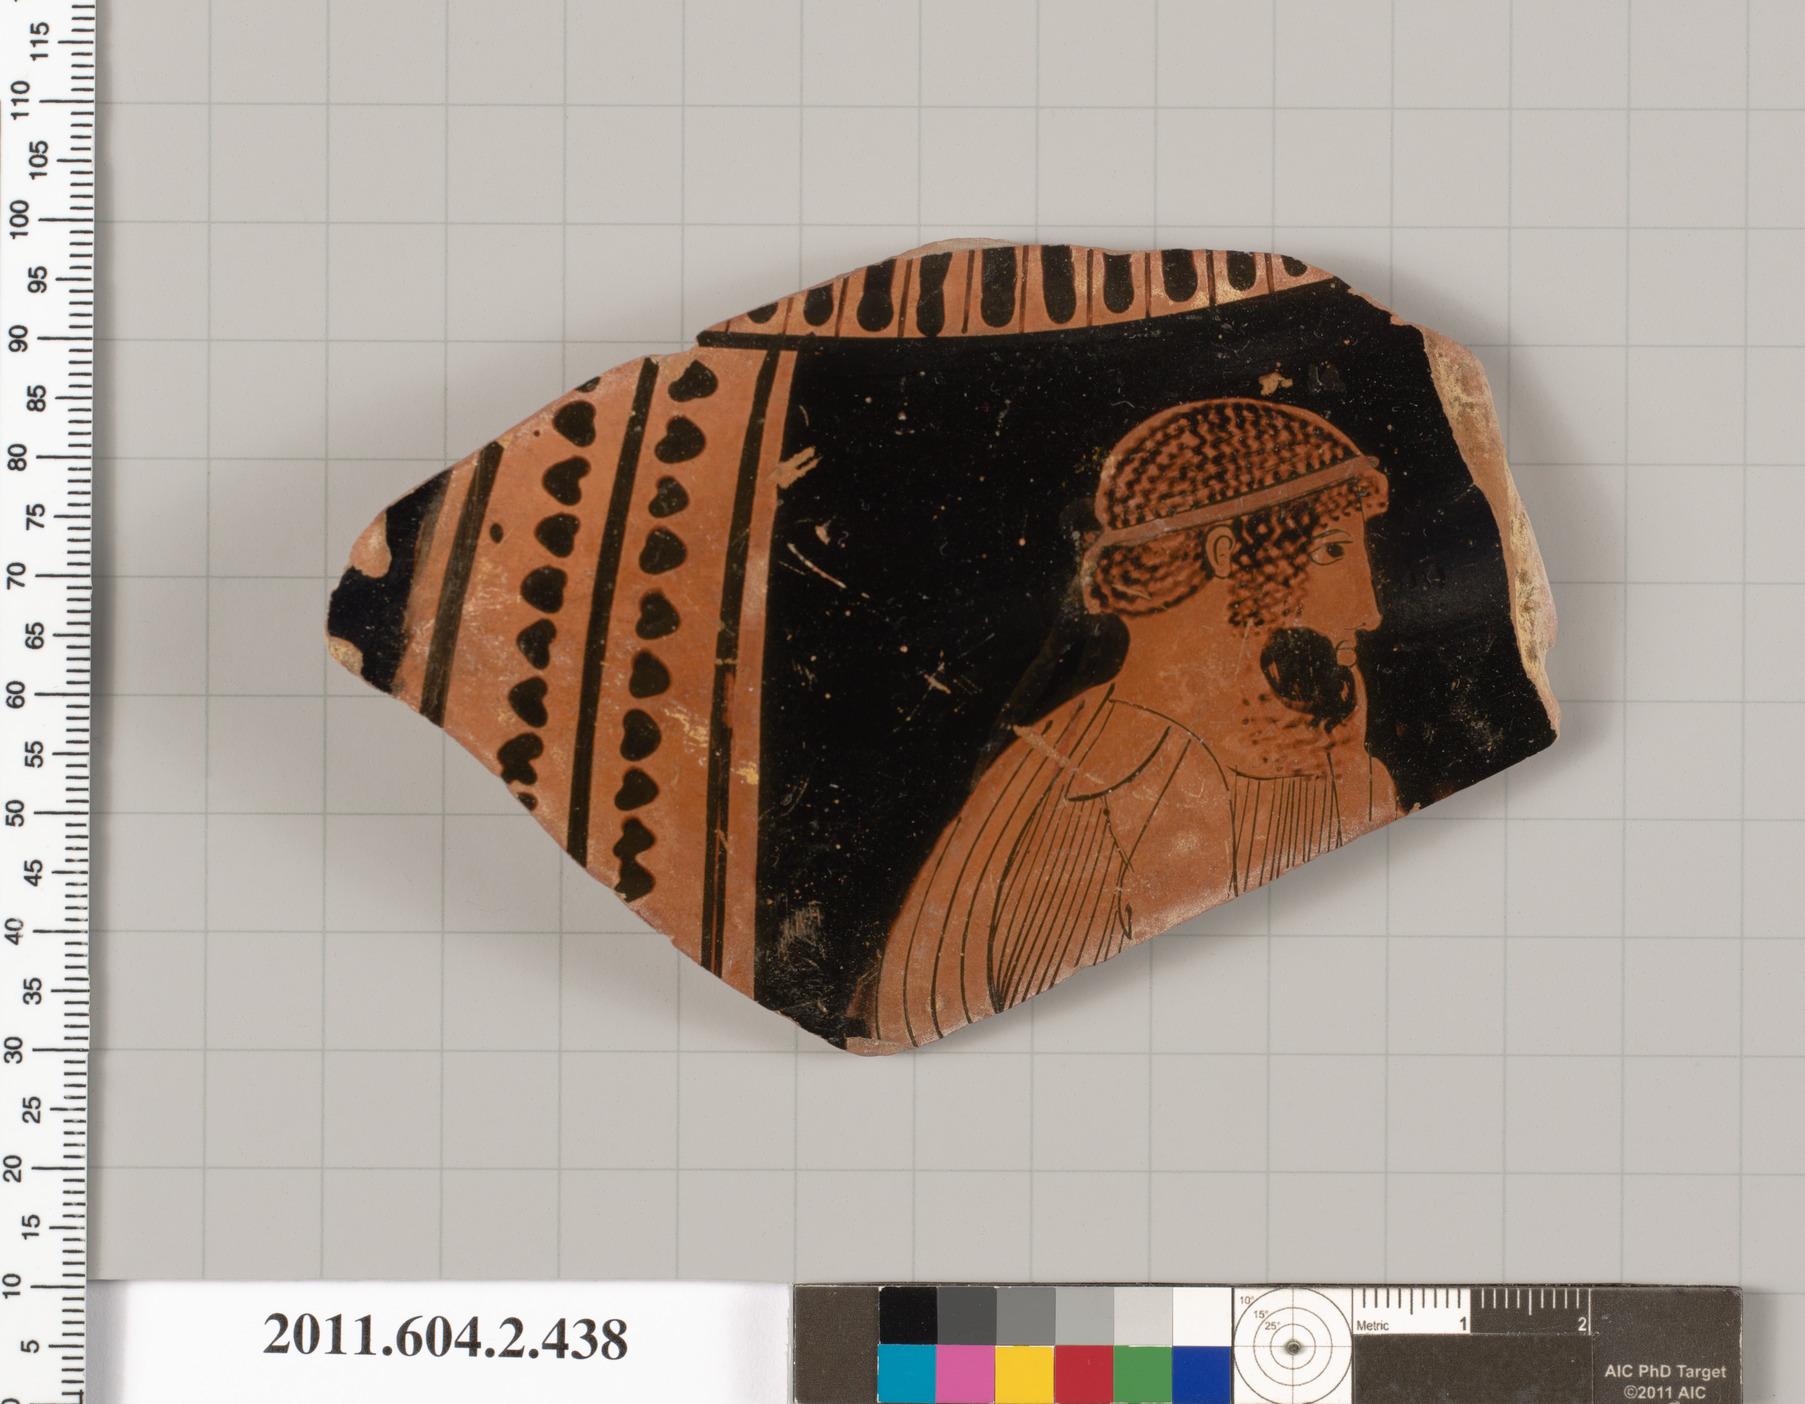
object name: column krater fragment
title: Terracotta fragment of a column-krater (bowl for mixing wine and water)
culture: greek, attic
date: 460-440 BCE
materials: terracotta